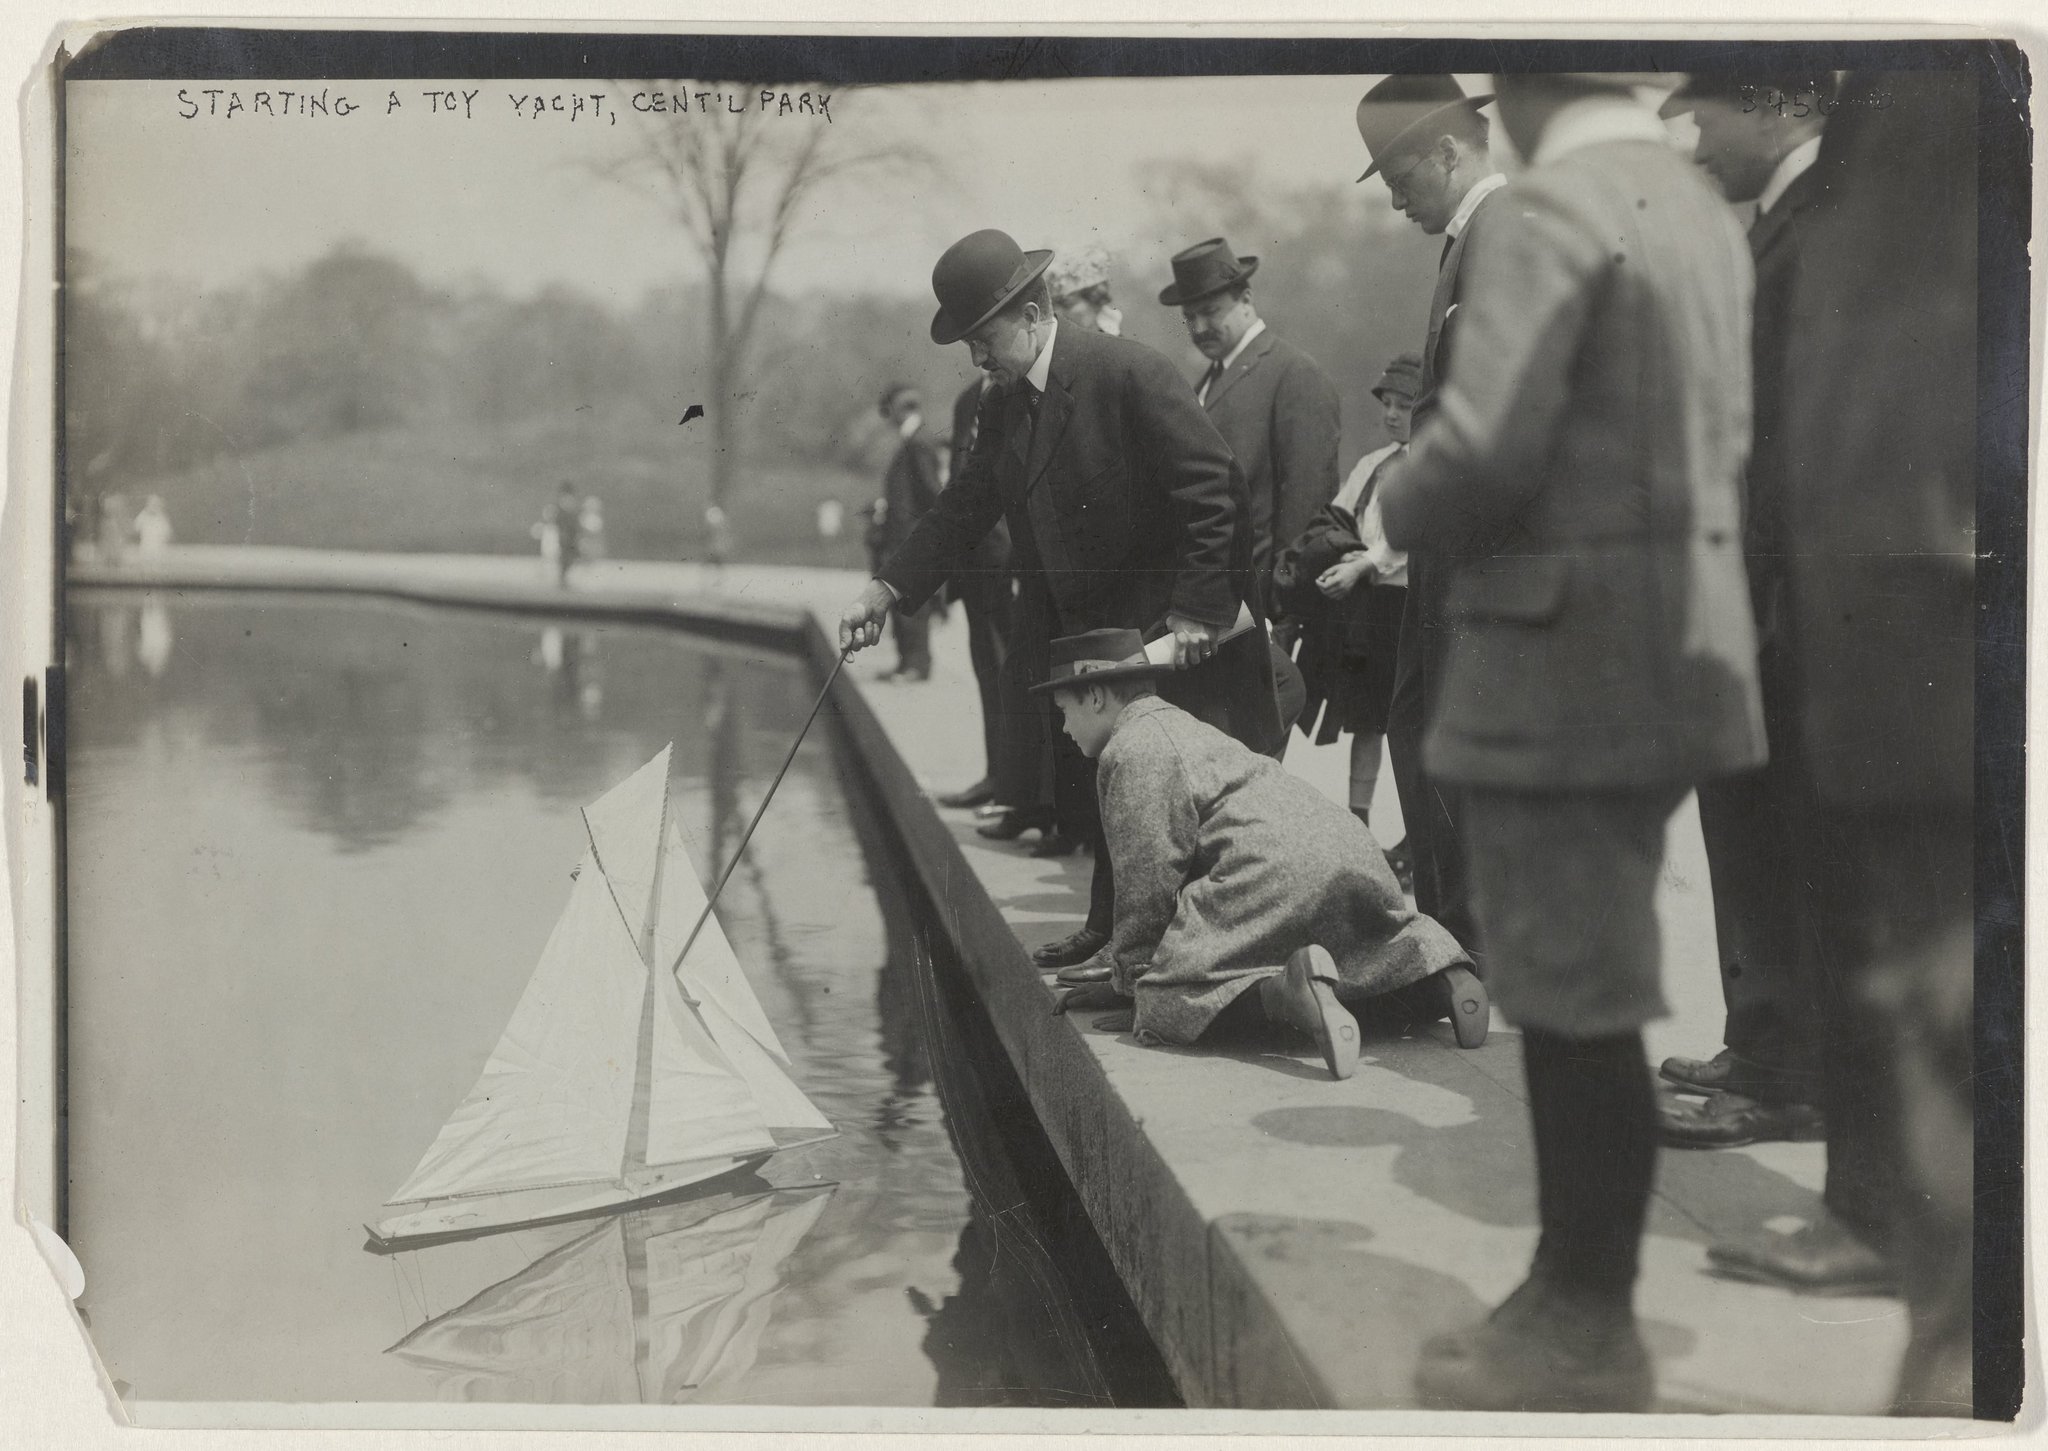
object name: photograph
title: Speelgoedbootje in een vijver in Central Park, New York City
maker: george grantham bain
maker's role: fotograaf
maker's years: 1865-1944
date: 1921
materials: paper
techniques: gelatin silver print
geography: new york city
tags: (playing with) boats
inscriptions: inscription: ‘CULVER PICTURES, INC./ 660 FIRST AVENUE/ NEW YORK, N.Y. 10016/ this picture is loaned for one/ reproduction only. Must not be used for // advertising without written permission./ Original must be returned within 30 days./ Obligatory Credit Line/ CULVER PICTURES’, inscription: ‘PLEASE CREDIT THE BAIN NEWS AGENCY/ FROM GEORGE GRANTHAM BAIN/ 32 UNION SQUARE EAST, N. Y./ This Picture not to be resold/ for your use only.’, inscription: ‘STARTING A TOY YACHT, CENT'L PARK/ 3456 [….]’